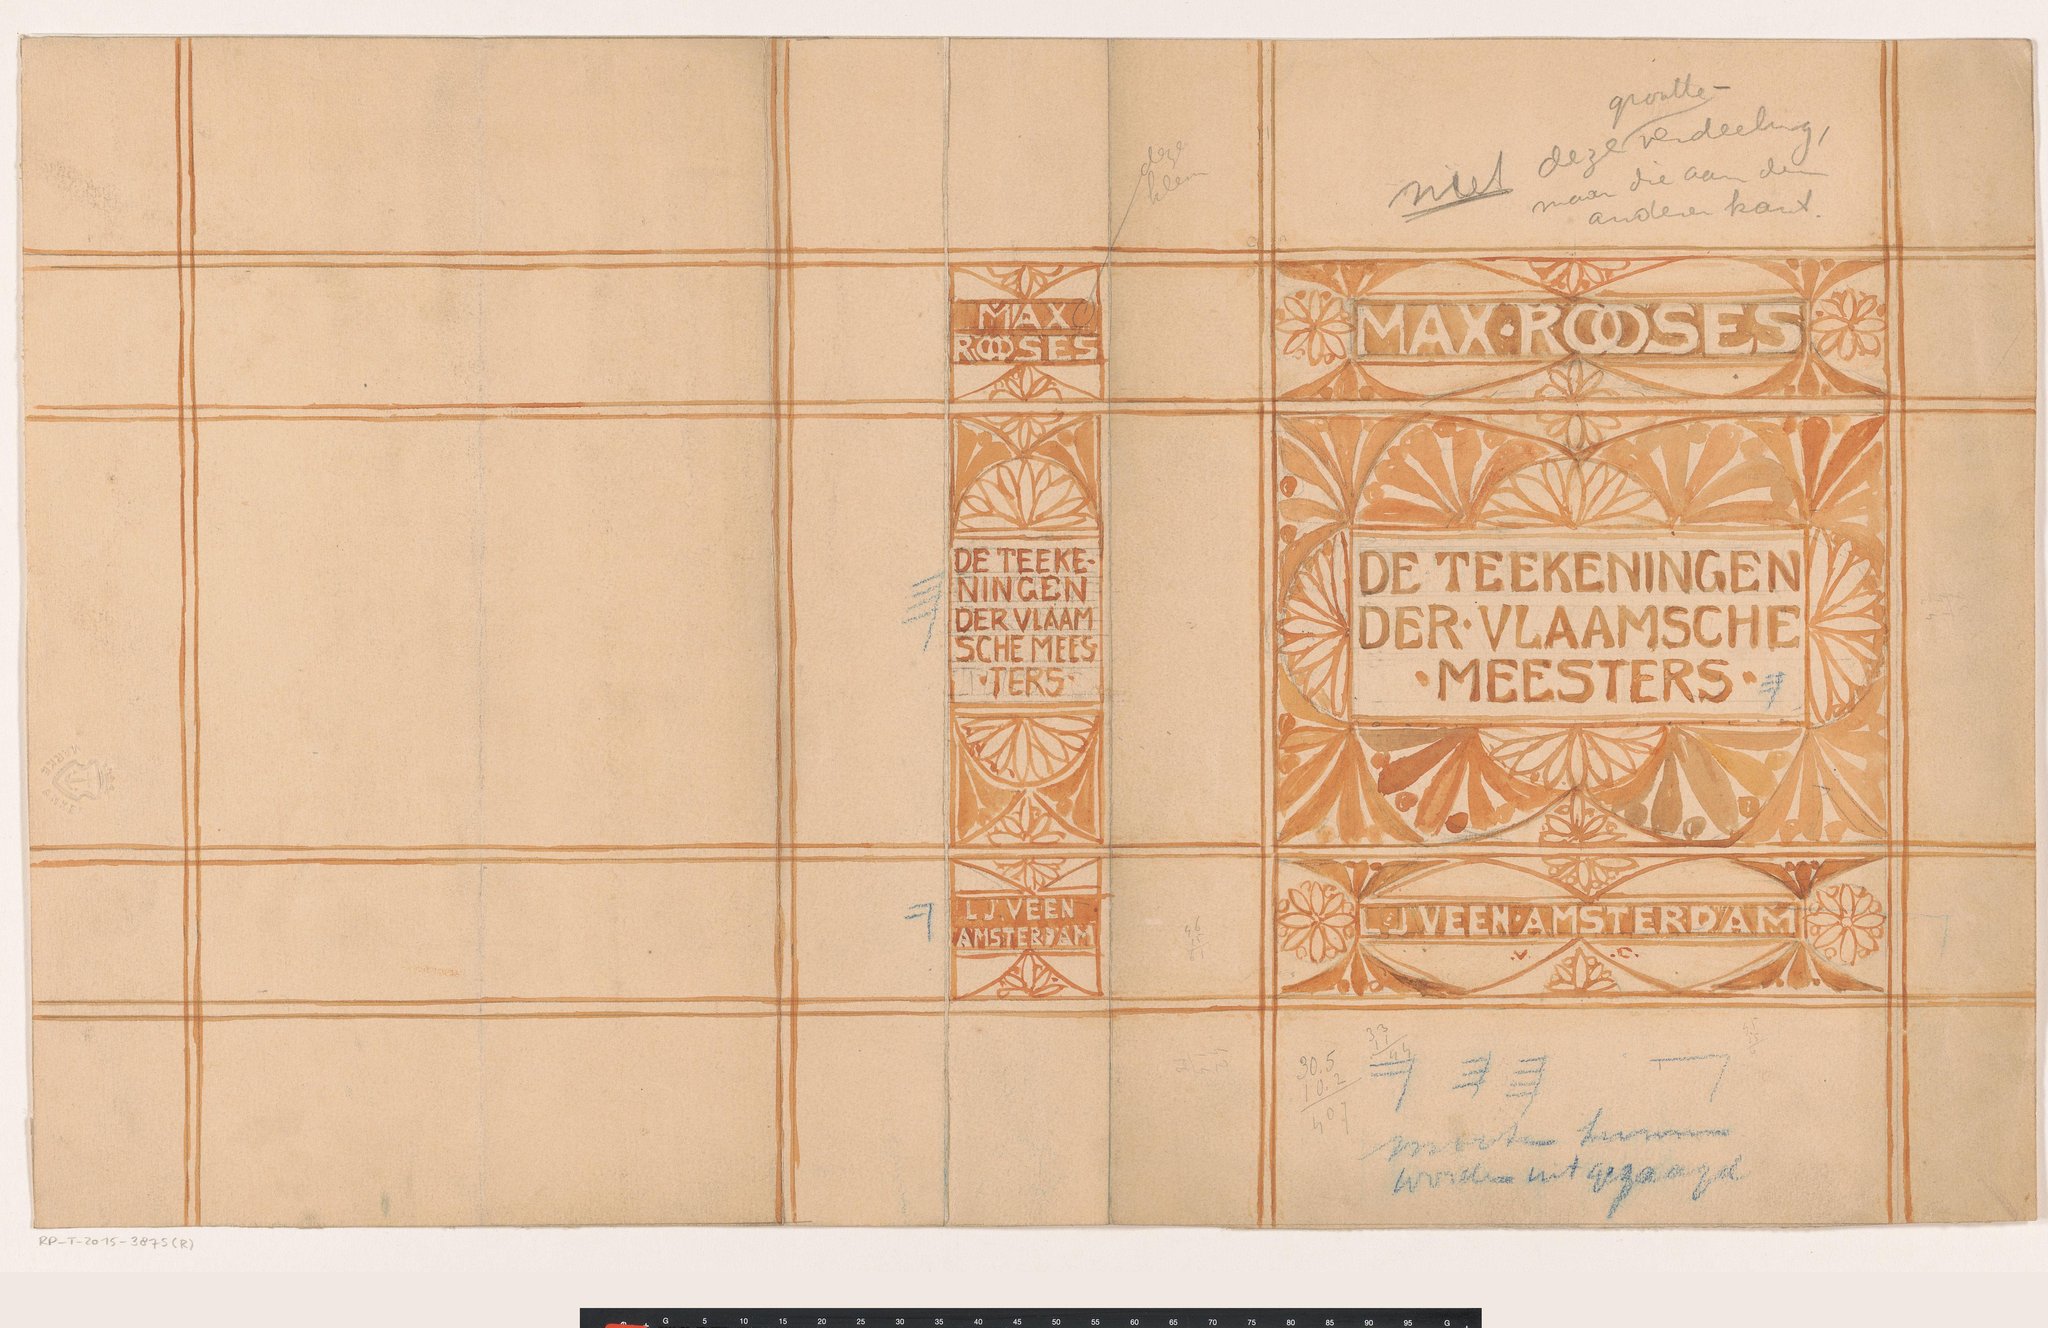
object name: drawing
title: Bandontwerp voor: Max Rooses, De teekeningen der Vlaamsche meesters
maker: johann georg van caspel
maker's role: draughtsman, print maker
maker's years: 1870-1928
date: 1900-1915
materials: chalk, paper, pencil, watercolor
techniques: brush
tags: flowers ~ ornament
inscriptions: factory mark: ‘MARKE ANKER’, annotation: ‘deze/ klein/ grootte-/ niet deze verdeeling,/ maar die aan den/ anderen kant’